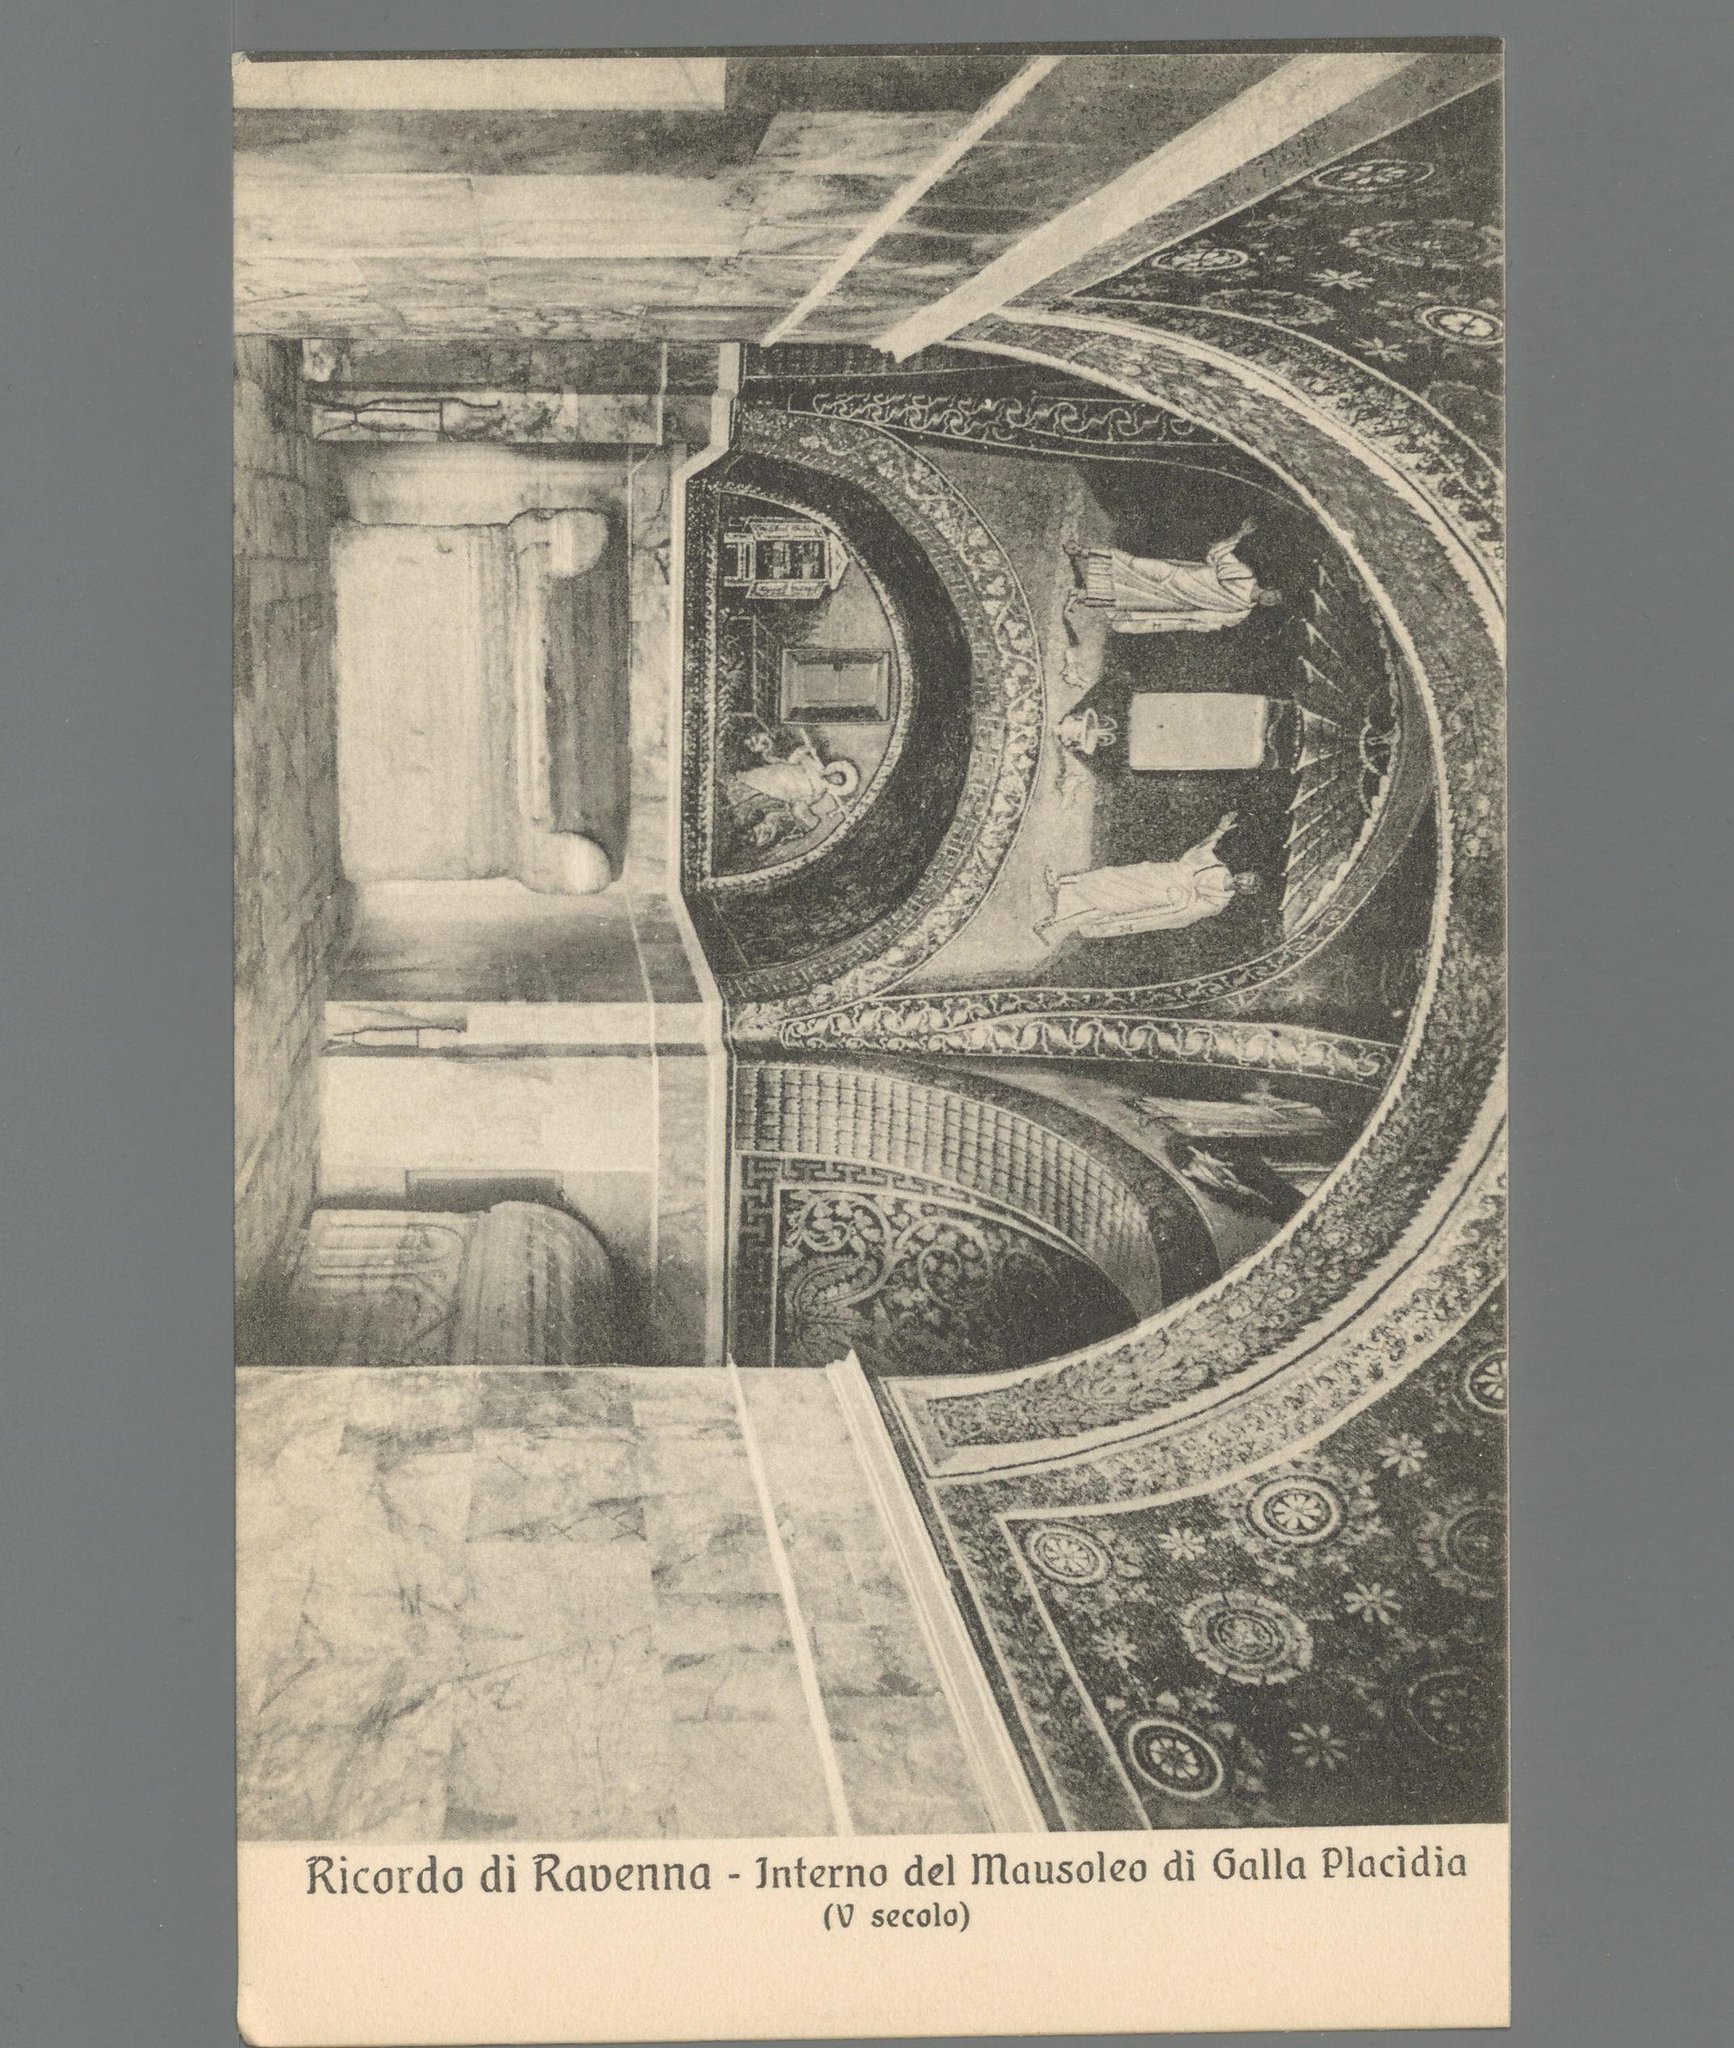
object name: photomechanical print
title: Ricordo di Ravenna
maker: Anonymous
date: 1906-1920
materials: cardboard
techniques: photograph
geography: ravenna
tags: mausoleum